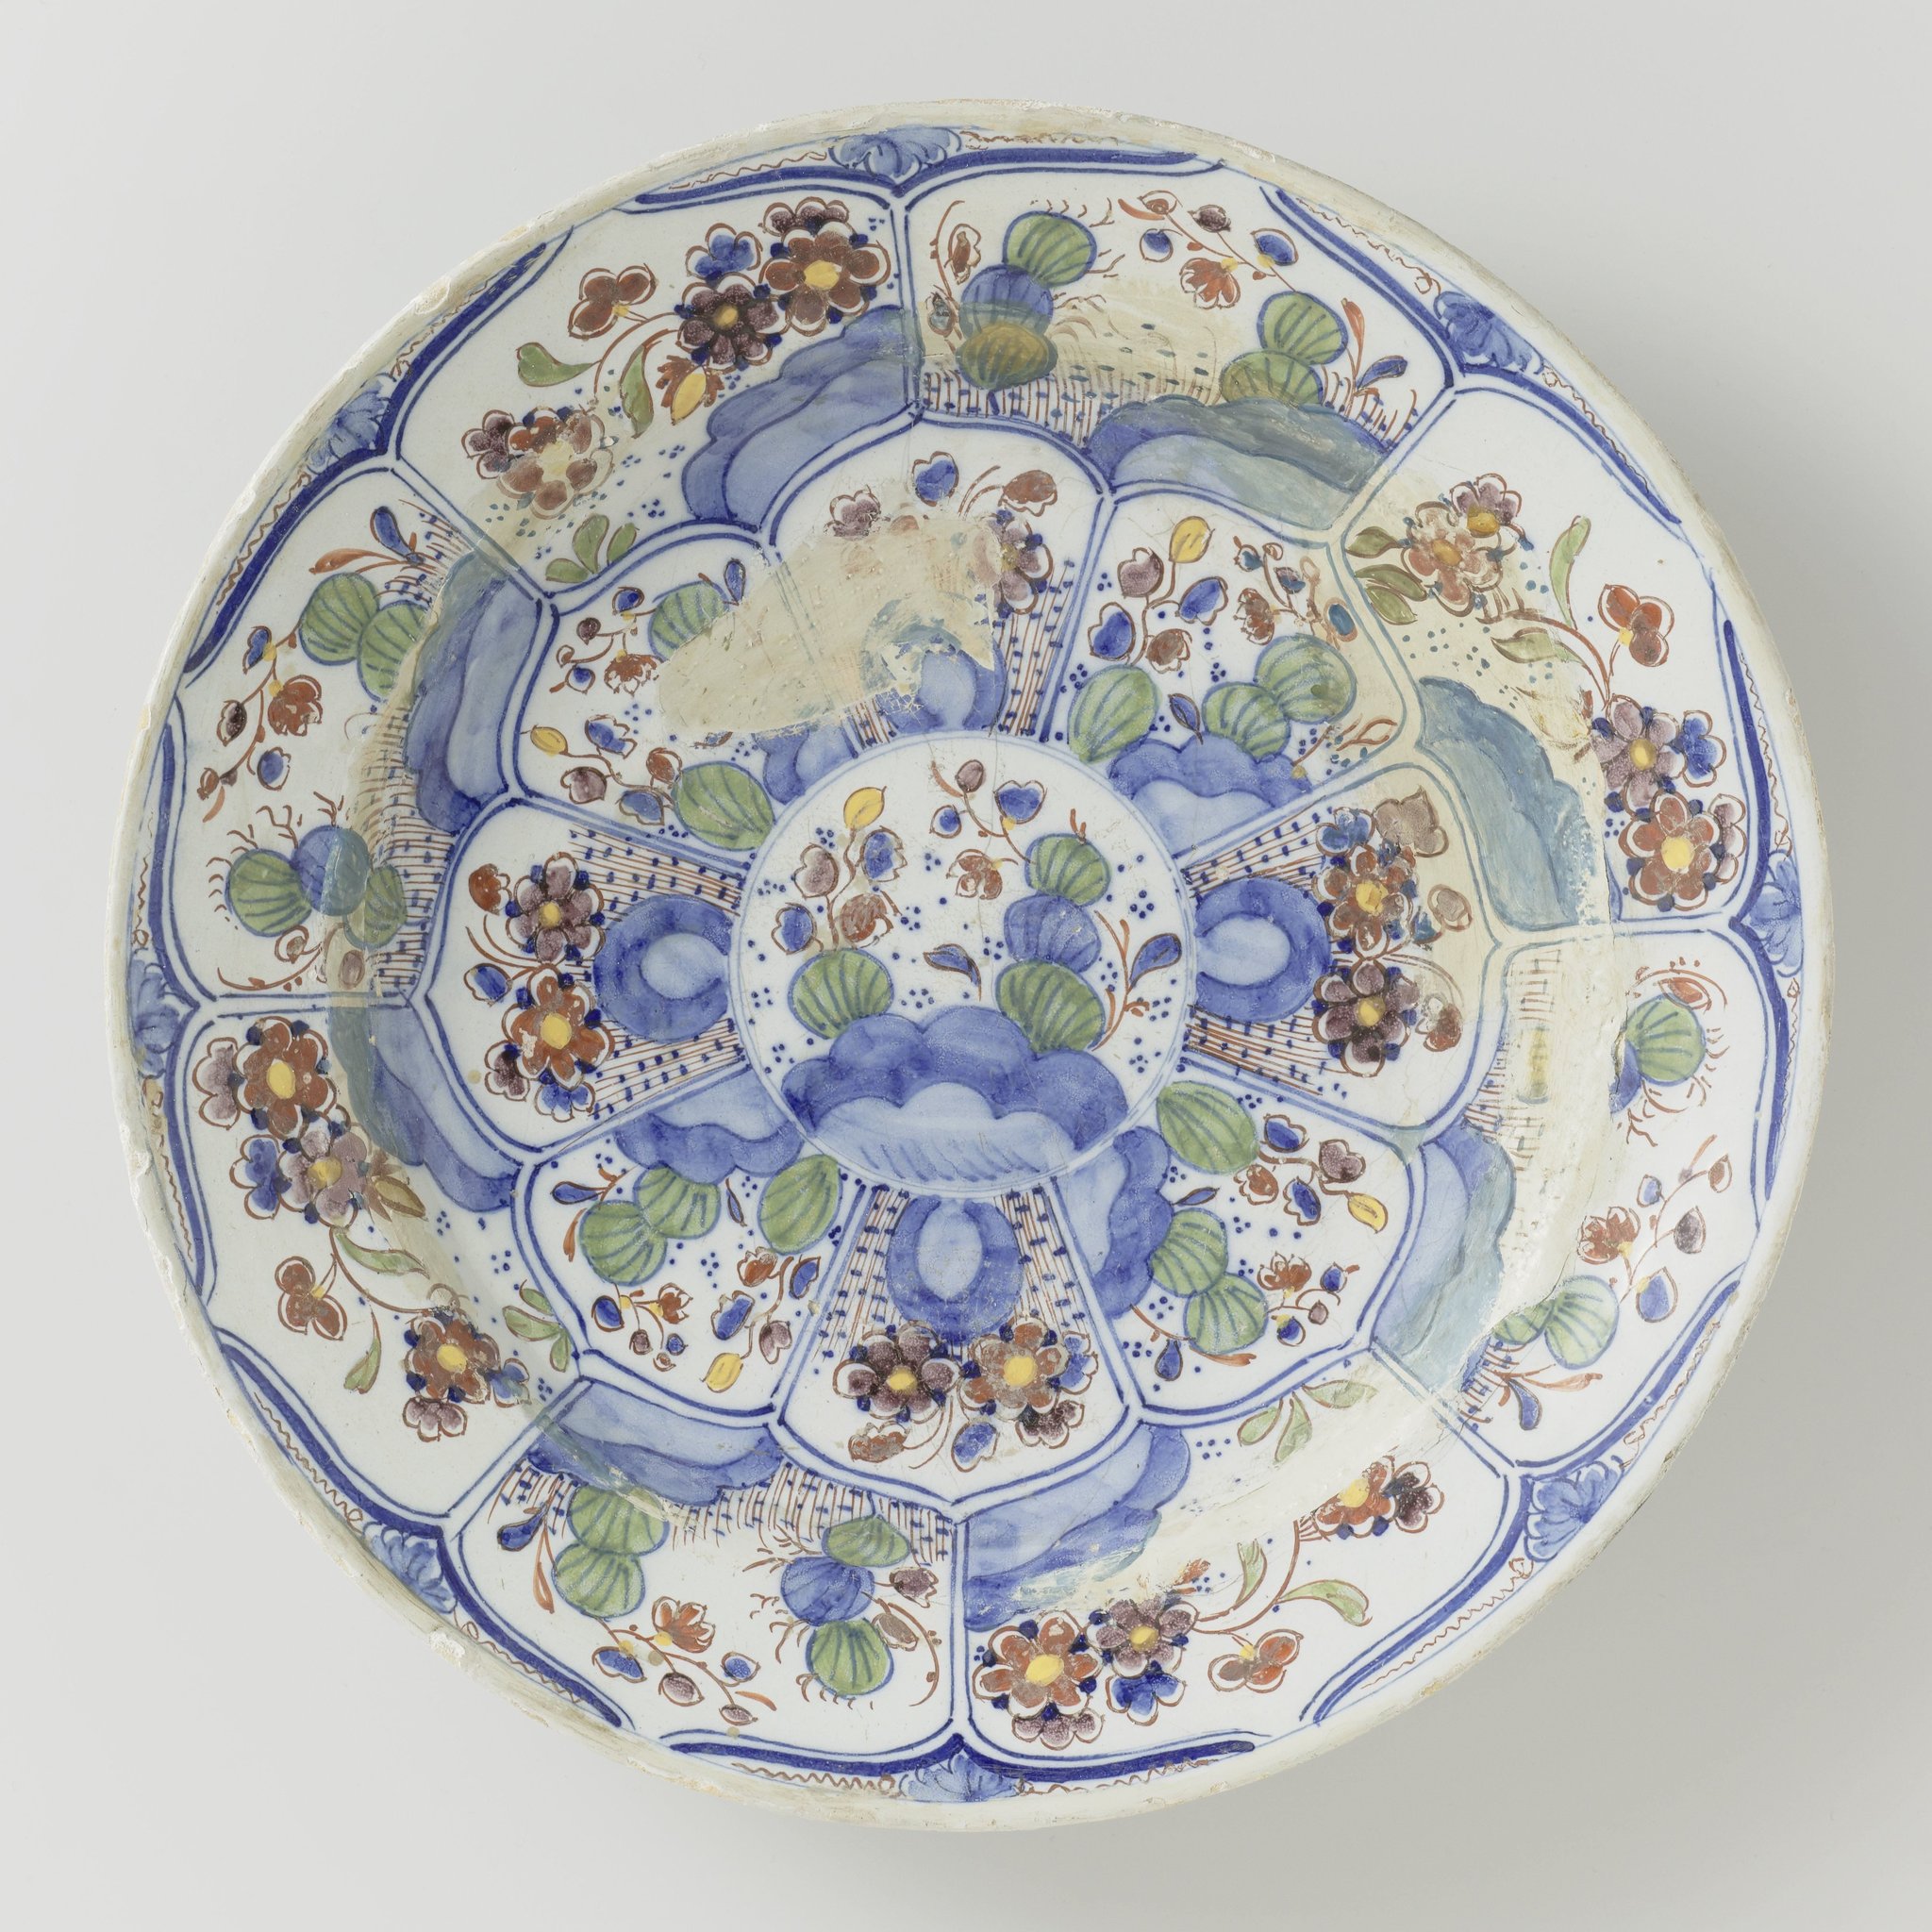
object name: platter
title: Schotel van veelkleurig beschilderde faience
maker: johannes van duijn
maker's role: plateelbakker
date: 1765-1780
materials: earthenware, glaze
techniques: painted, polychromy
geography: delft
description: Ronde schotel van veelkleurig beschilderde faience. Op het plat is een cirkel met daarbinnen planten op een grond geschilderd, daar omheen acht vakken met planten en bloemen. De rand is verdeeld in acht vakken waarbinnen planten en bloemen. De gebruikte kleuren zijn: blauw, groen, rood, paars en geel. Bij de schotel horen vijf identieke schotels met invnrs. BK-NM-13347-a, BK-NM-133347-b, BK-NM-13347-c, BK-NM-13347-e, BK-NM-13347-f. De schotel is gemerkt. De glazuur geheel losgelaten.